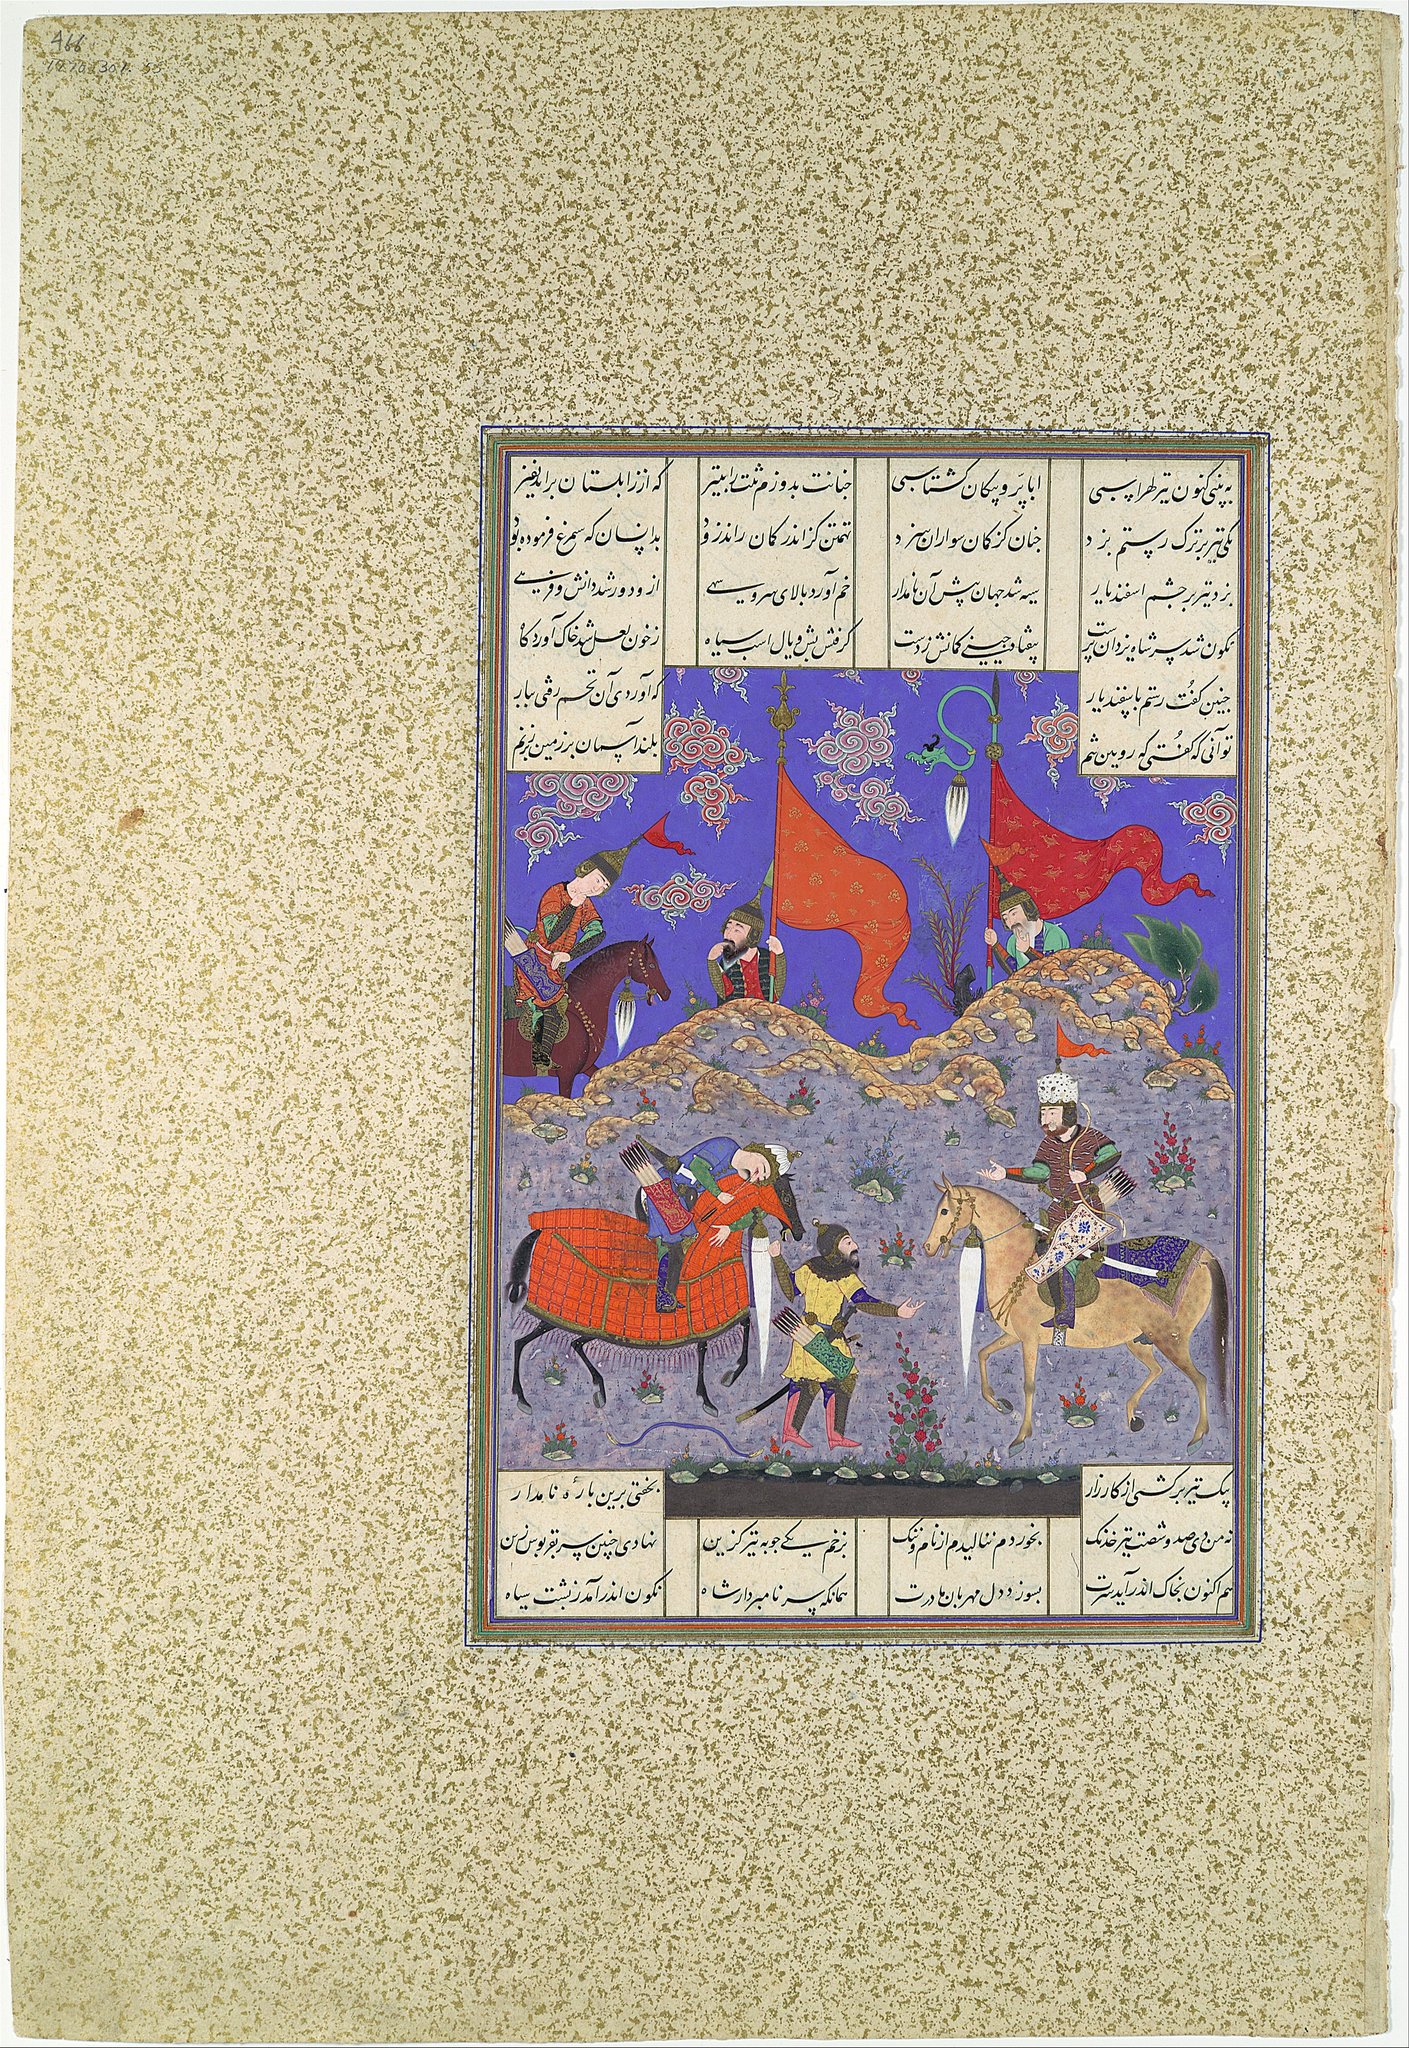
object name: folio from an illustrated manuscript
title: "Rustam Slays Isfandiyar", Folio 466r from the Shahnama (Book of Kings) of Shah Tahmasp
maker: abu'l qasim firdausi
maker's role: author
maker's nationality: iranian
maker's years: 935-1020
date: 1525-1530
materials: gold, ink, paper, silver, watercolor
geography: iran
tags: men,horses,flags